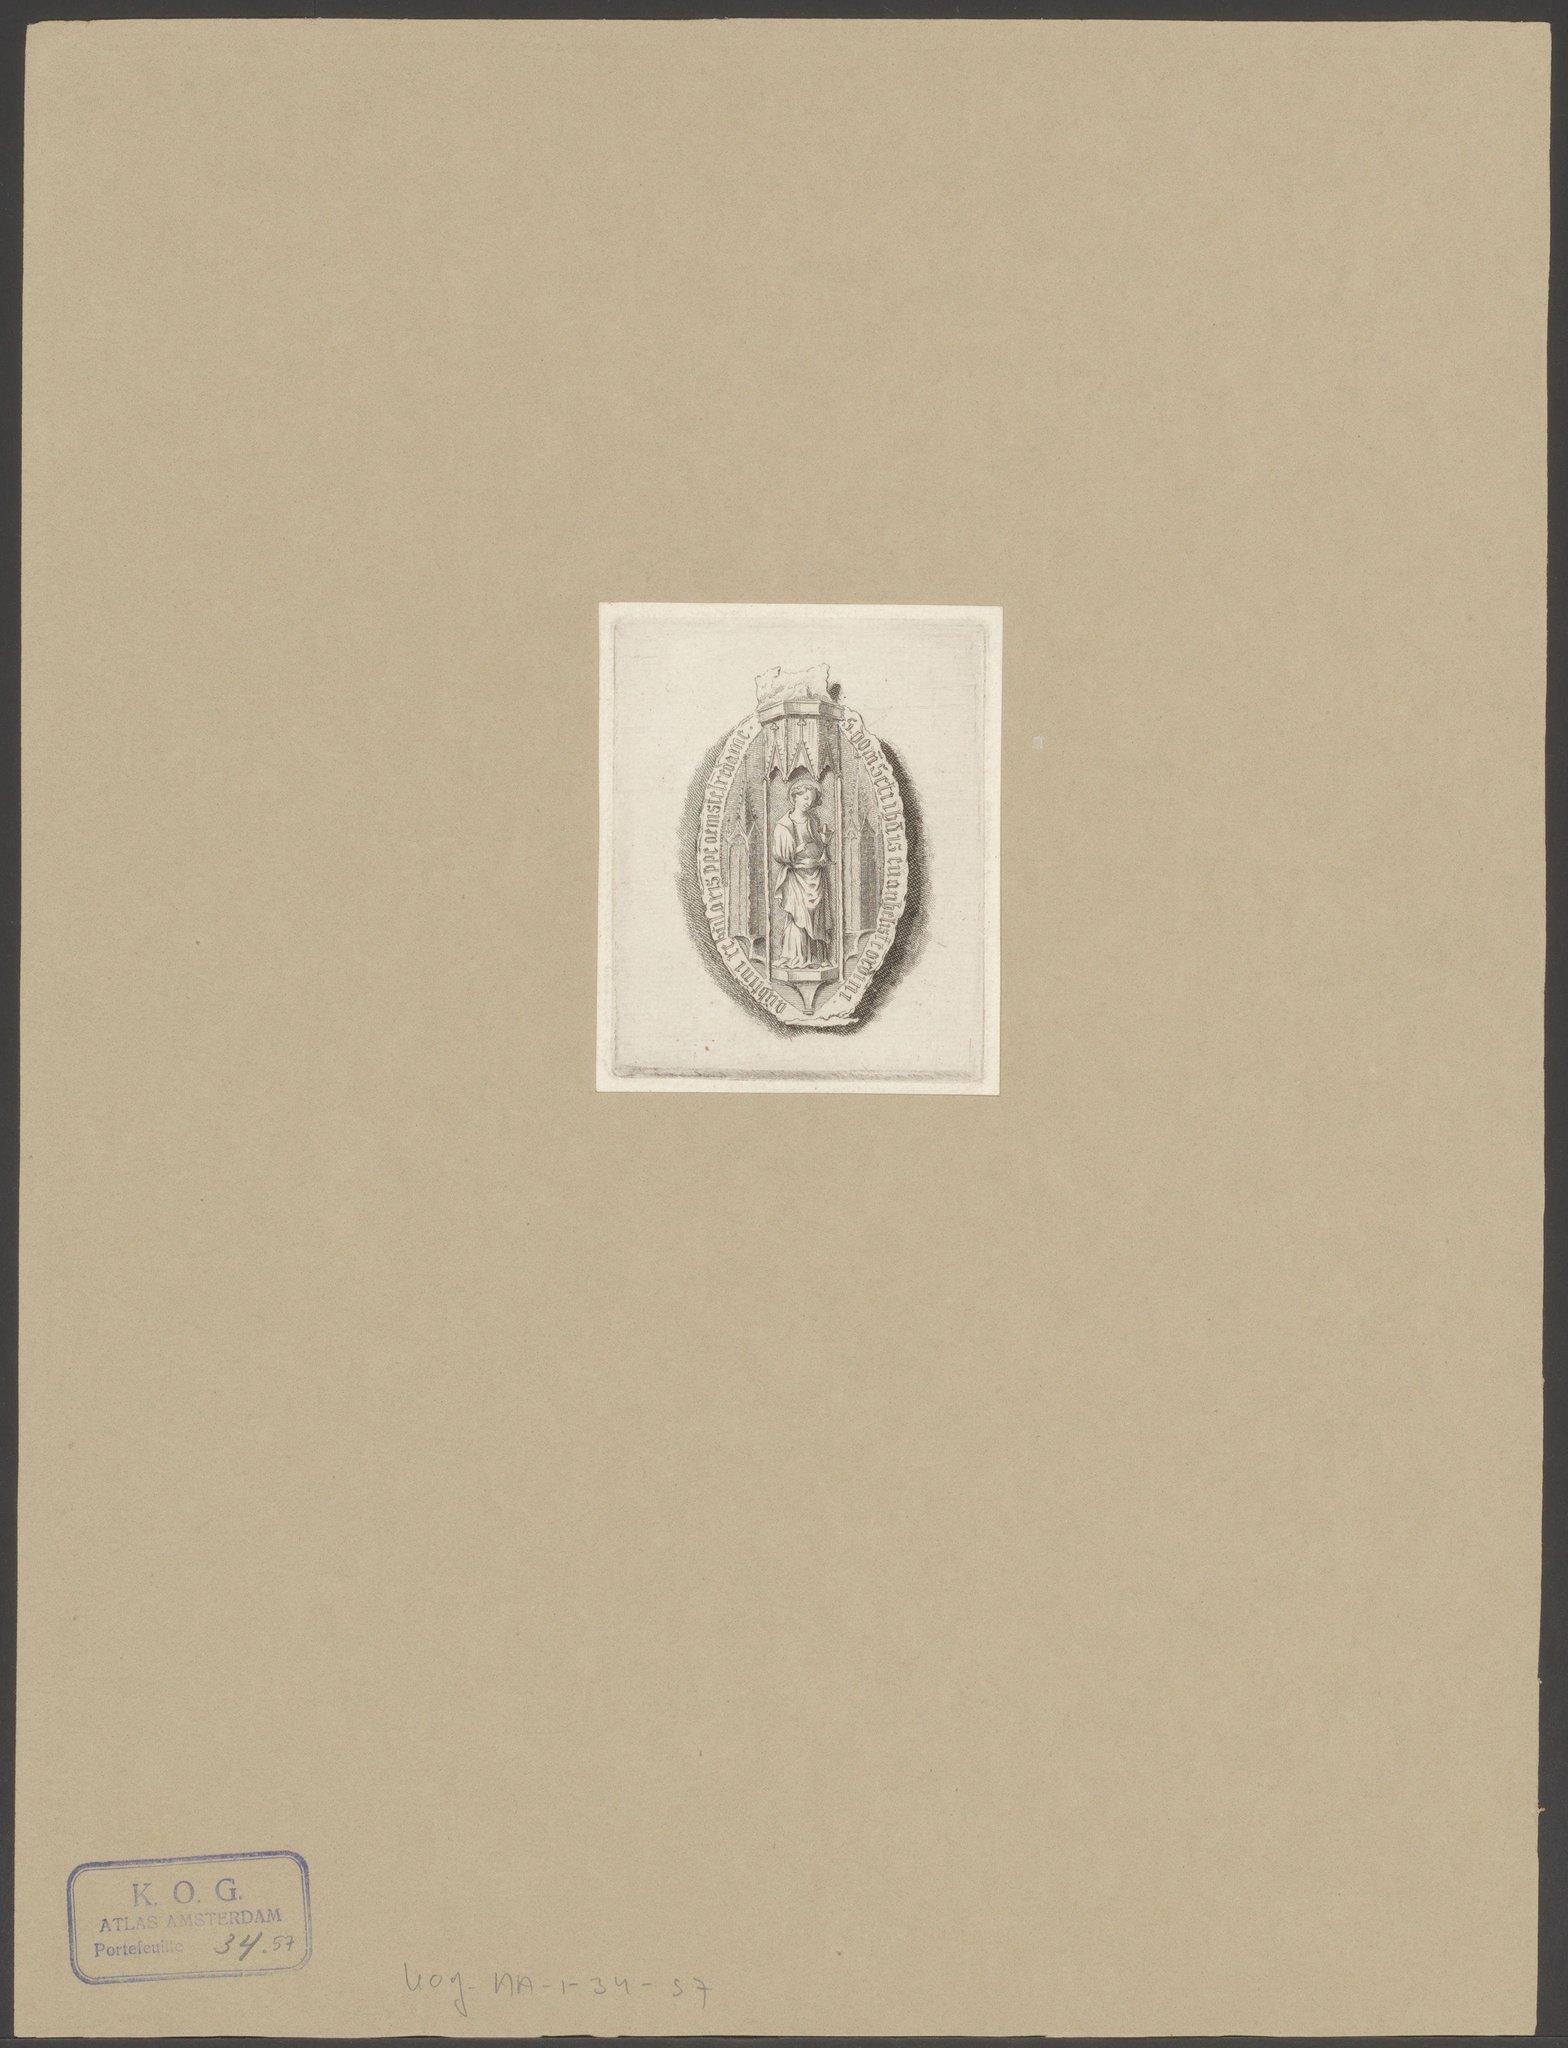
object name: print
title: Zegel met heilige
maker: Anonymous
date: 1700-1800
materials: paper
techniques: etching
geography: northern netherlands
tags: saints, seal, stamp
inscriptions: collector's mark: Lugt 1641b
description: Onderwerpsrubriek binnen de Atlas Amsterdam: Kerkwezen: R.K. Gemeenten: Kloosters.